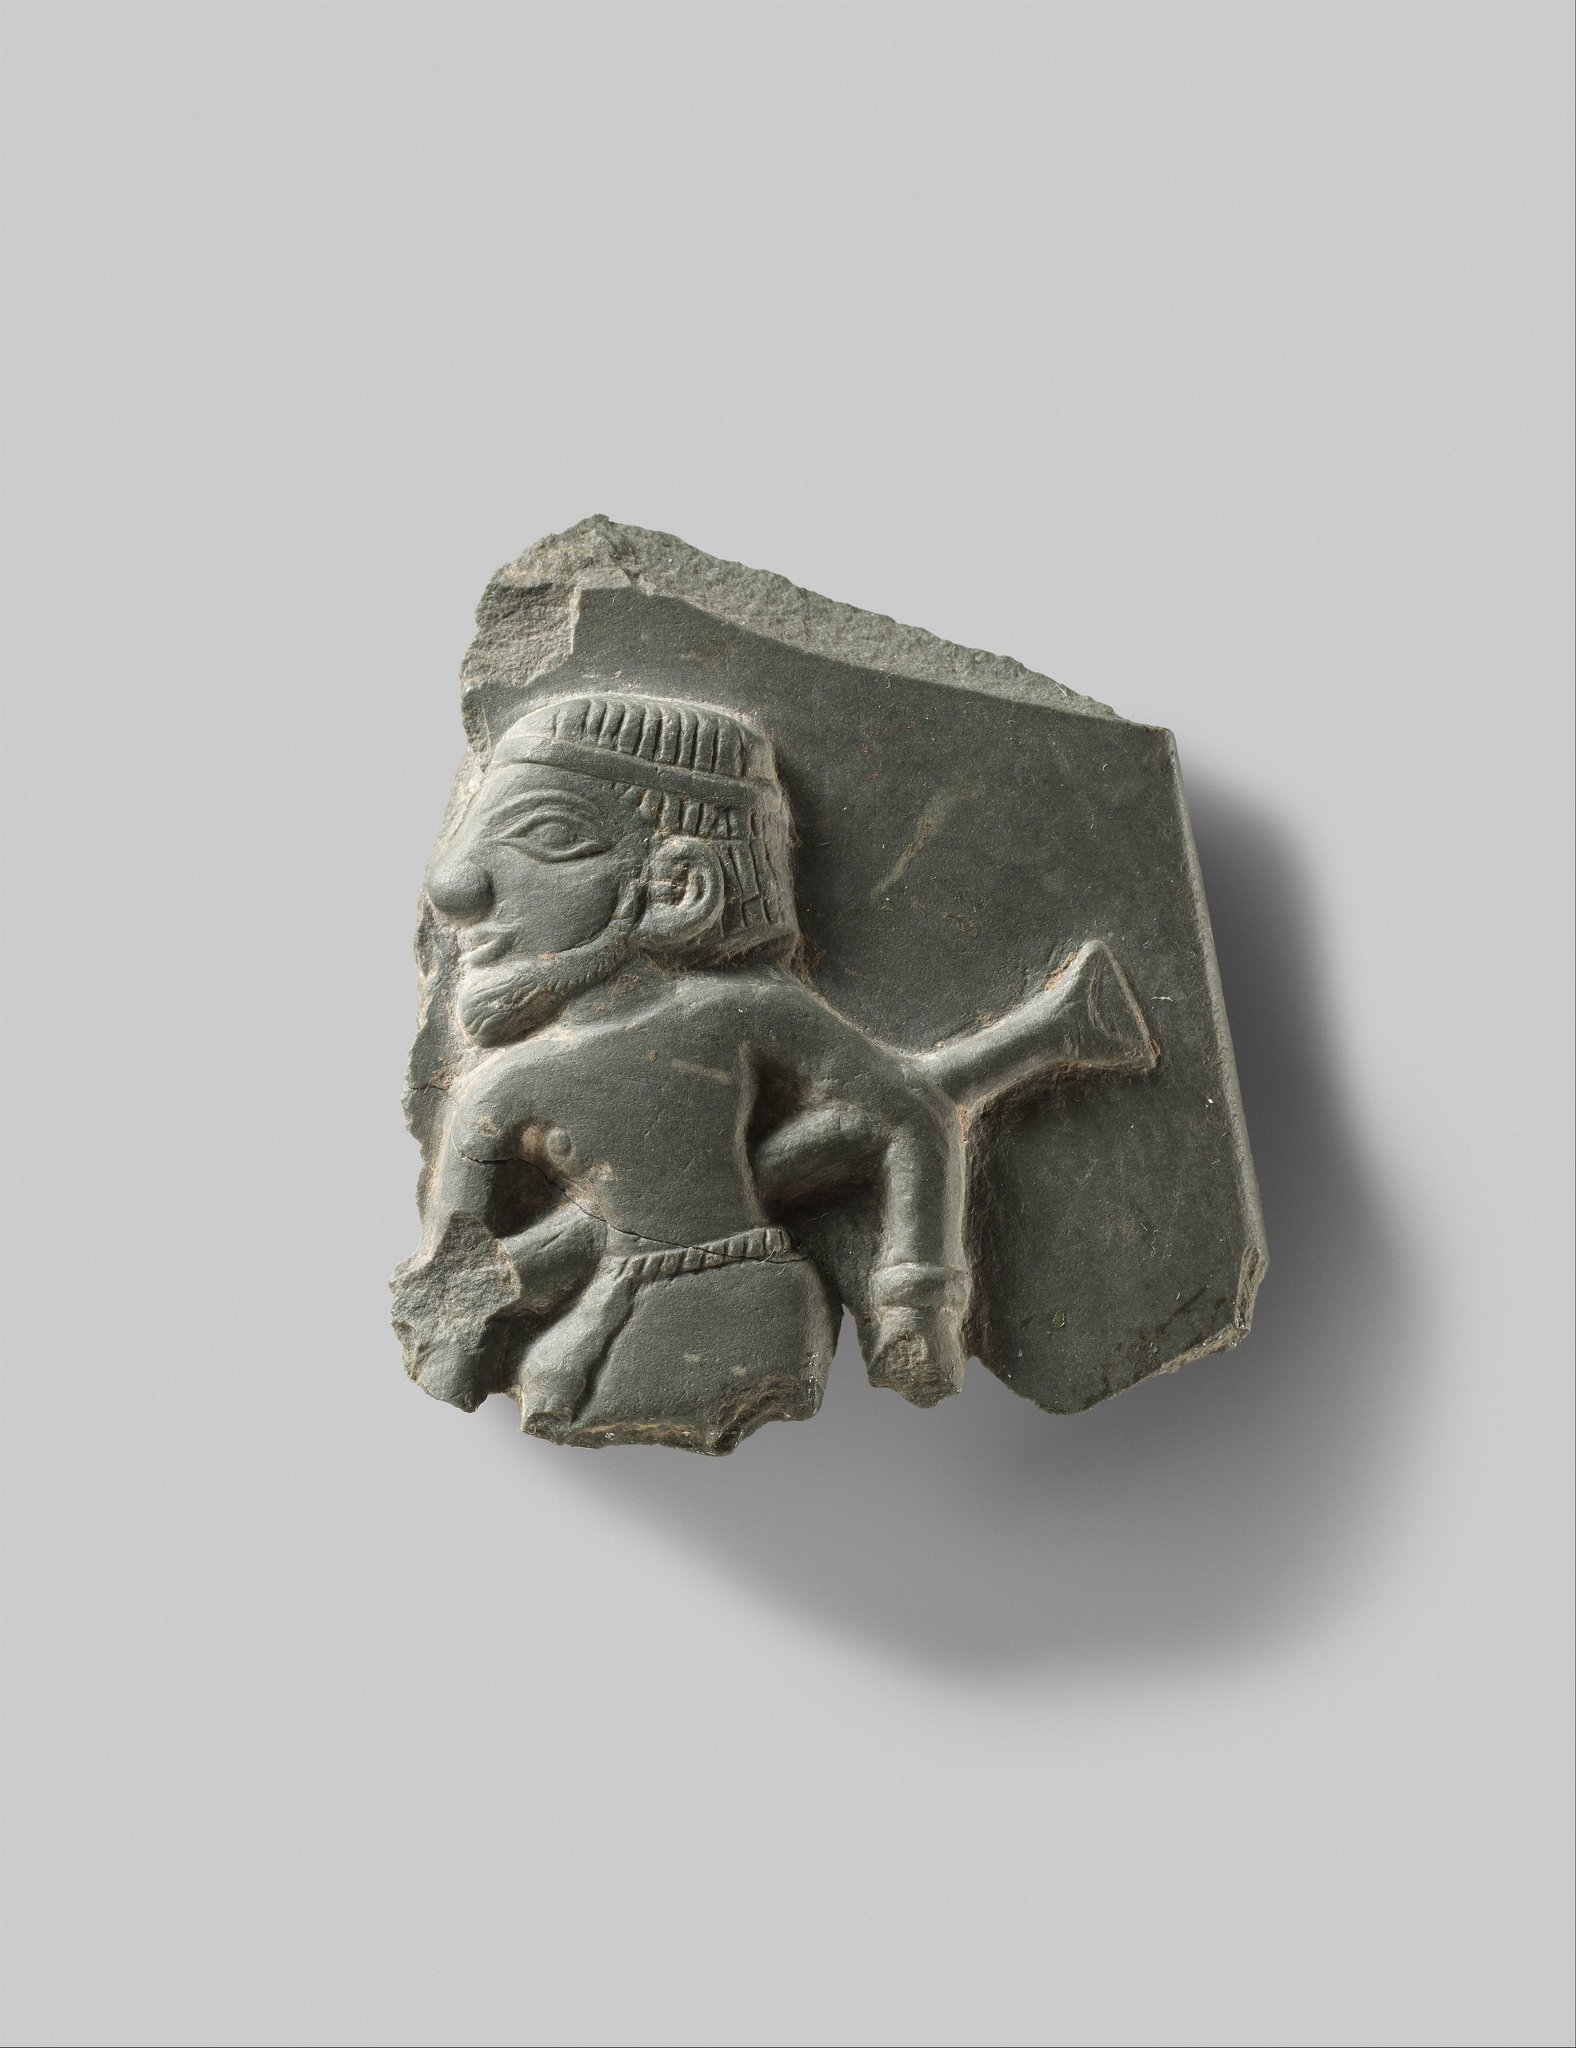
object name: palette, man pierced by arrow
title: Fragment of a ceremonial palette illustrating a man and a type of staff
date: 3200-3100 BCE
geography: egypt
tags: men